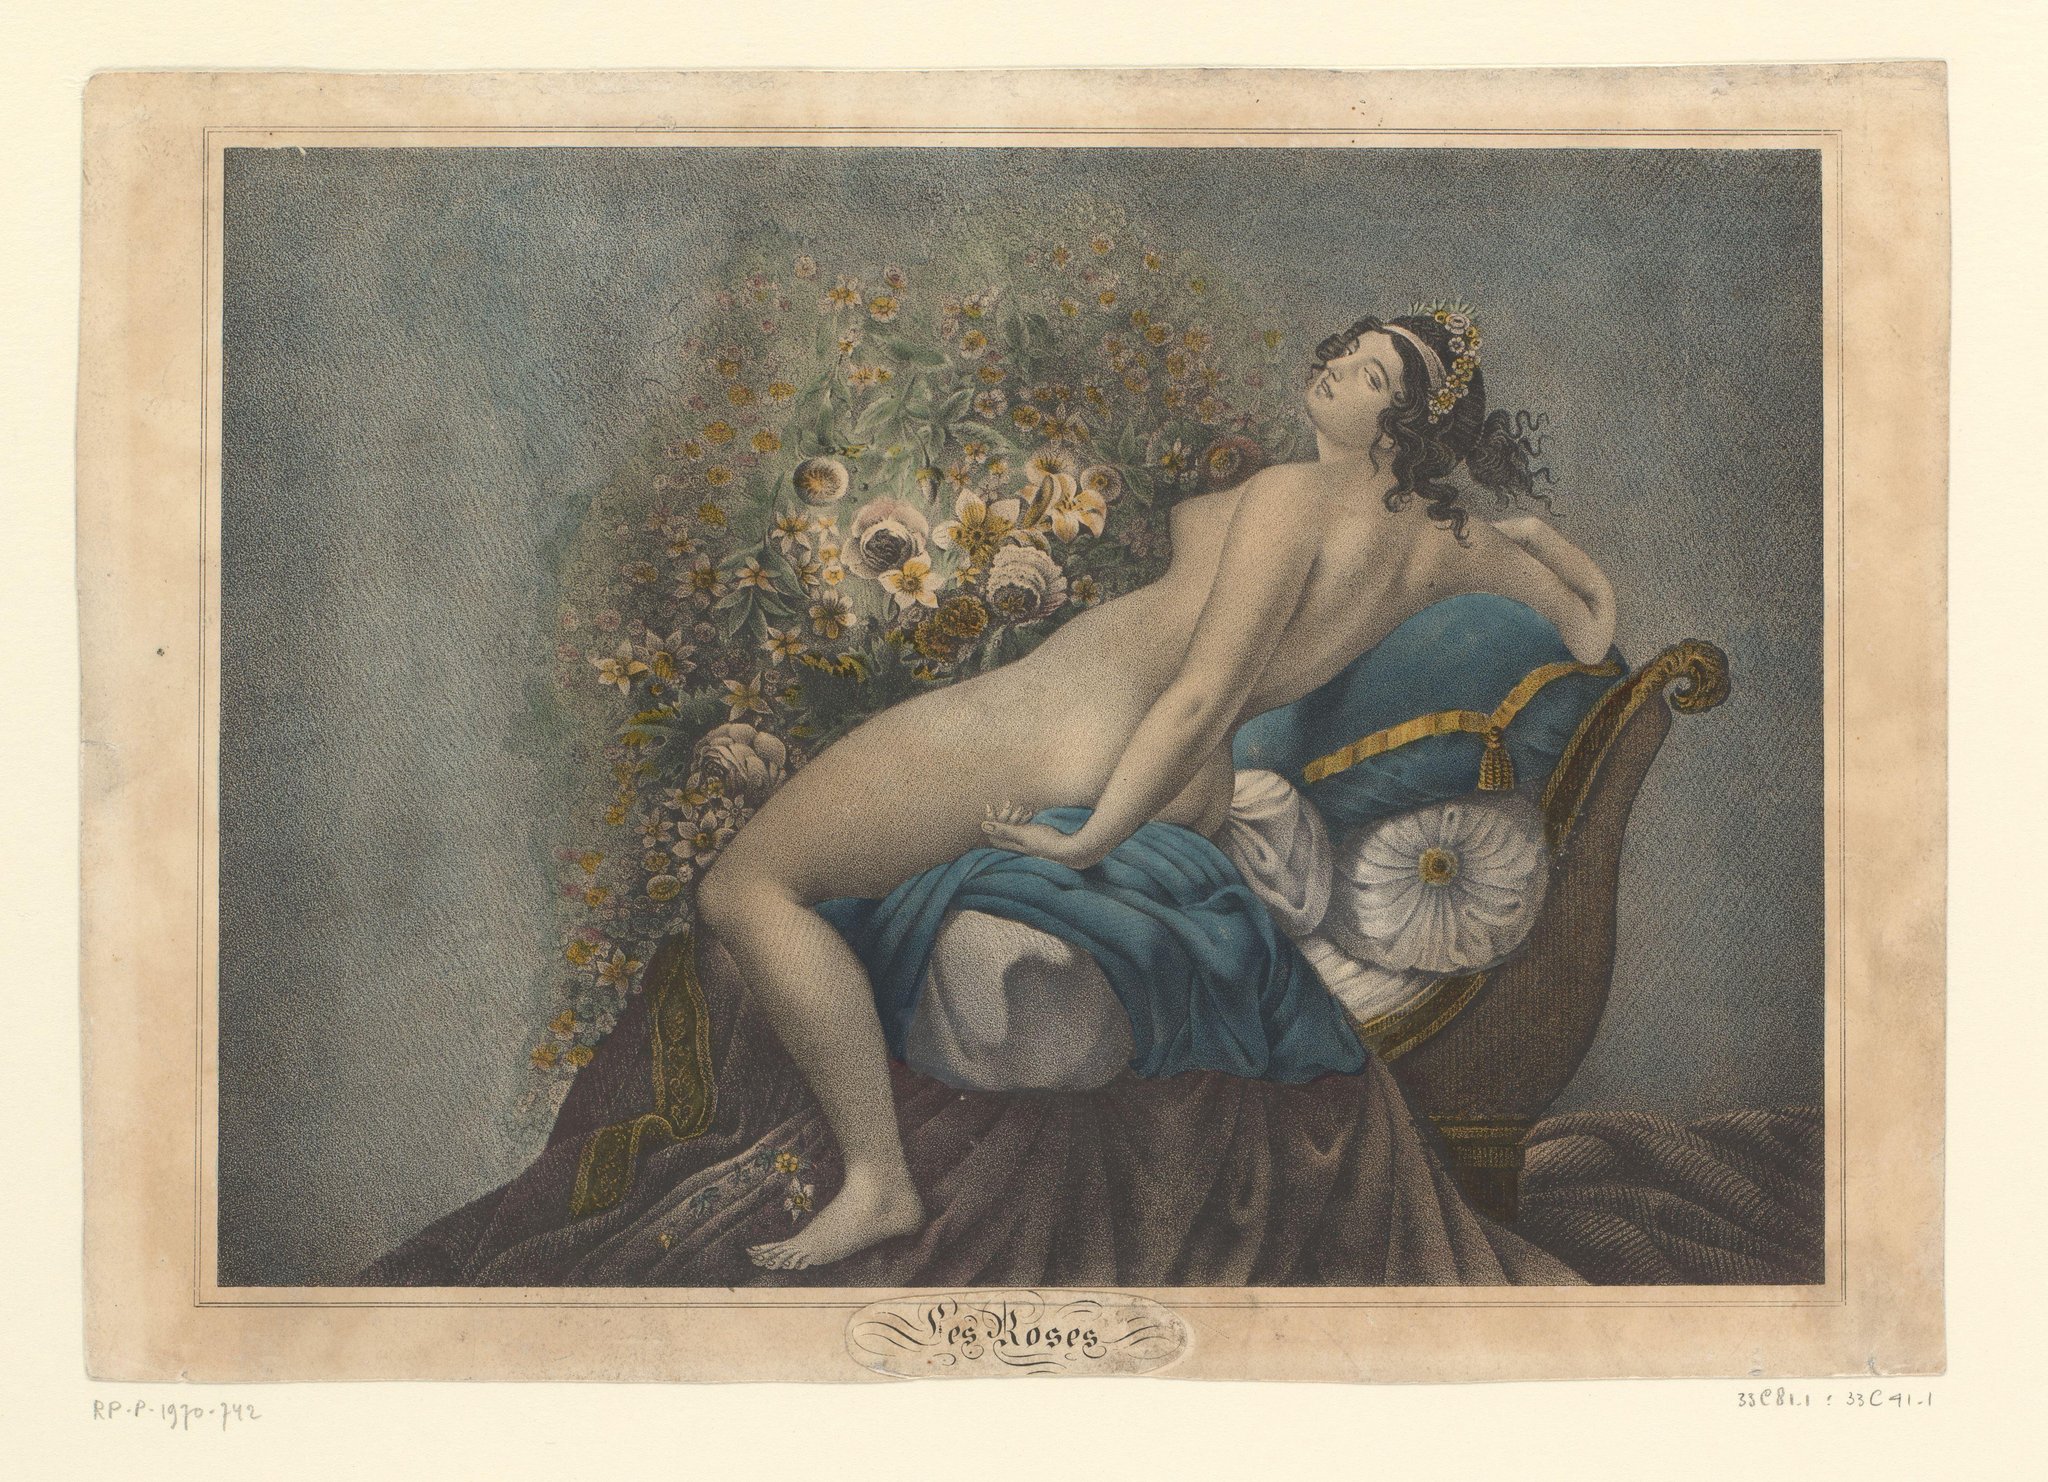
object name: print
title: Vrouw op chaise longue met bloemen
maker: Anonymous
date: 1830-1860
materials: paper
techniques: printmaking, etching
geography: france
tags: woman (showing herself) undressed, quasi-nude, flowers: rose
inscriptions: collector's mark: Lugt 2228